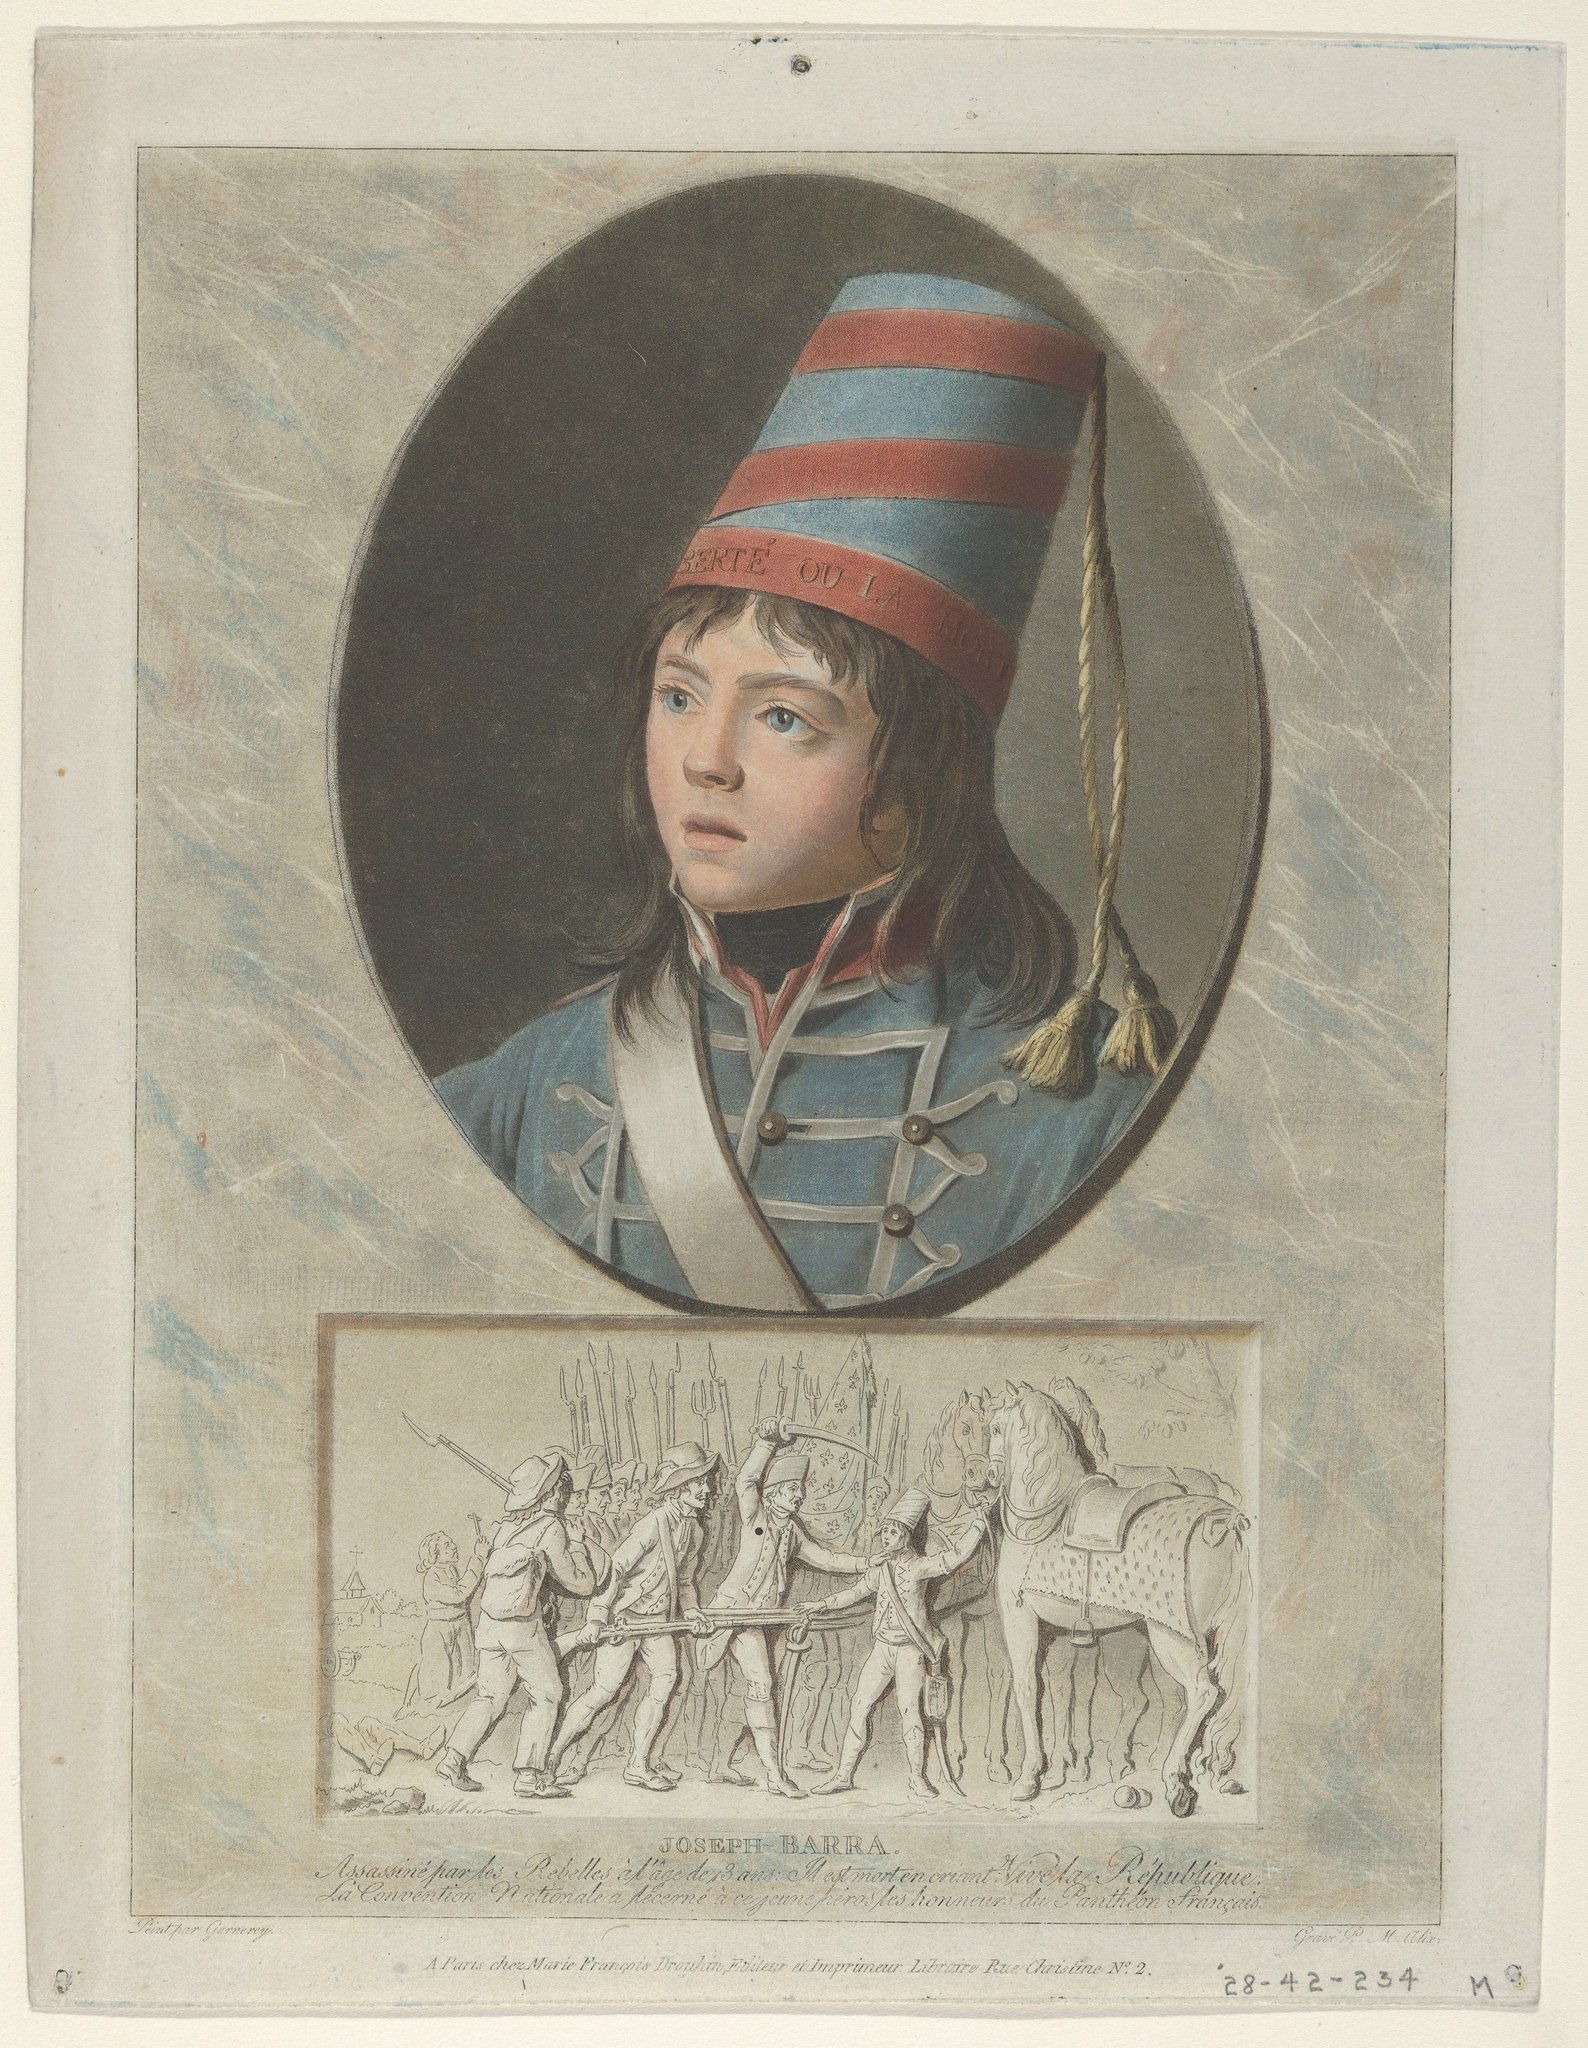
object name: print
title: Joseph Barra after F. Garnerey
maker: pierre michel alix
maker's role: artist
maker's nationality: french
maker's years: 1762-1817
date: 1795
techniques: aquatint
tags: spears,men,portraits,horses,crowd